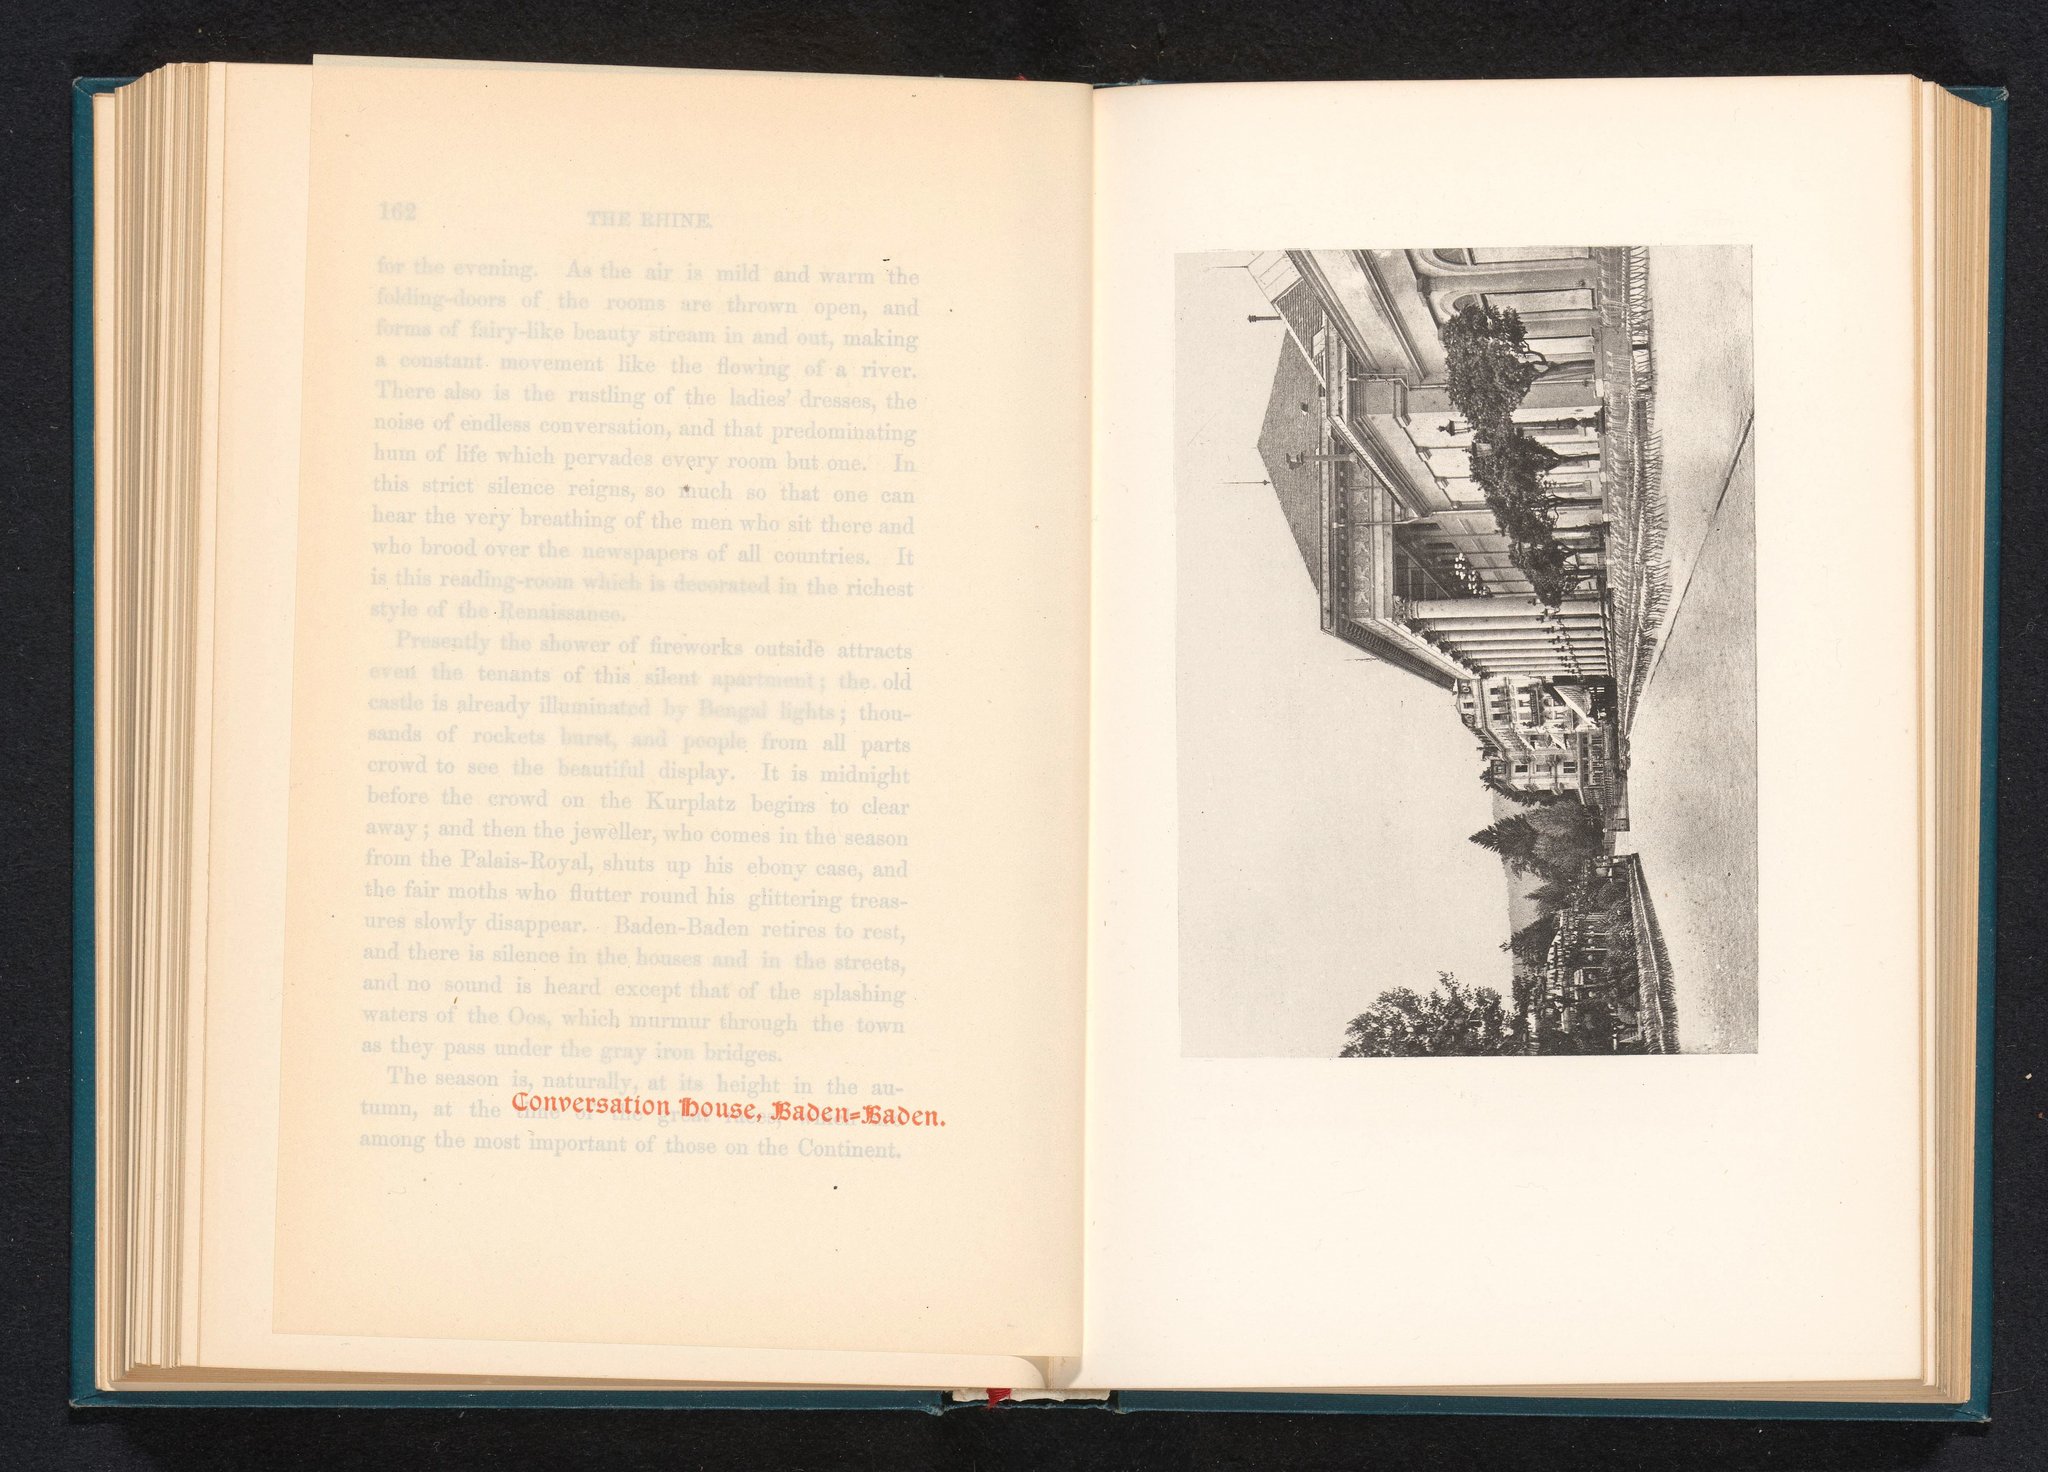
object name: page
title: Exterieur van het Kurhaus van Baden-Baden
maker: Anonymous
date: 1889-1899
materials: paper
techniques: photoaquatint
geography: baden-baden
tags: watering-place, spa, façade (of house or building)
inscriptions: title: ‘Conversation house, Baden-Baden.’